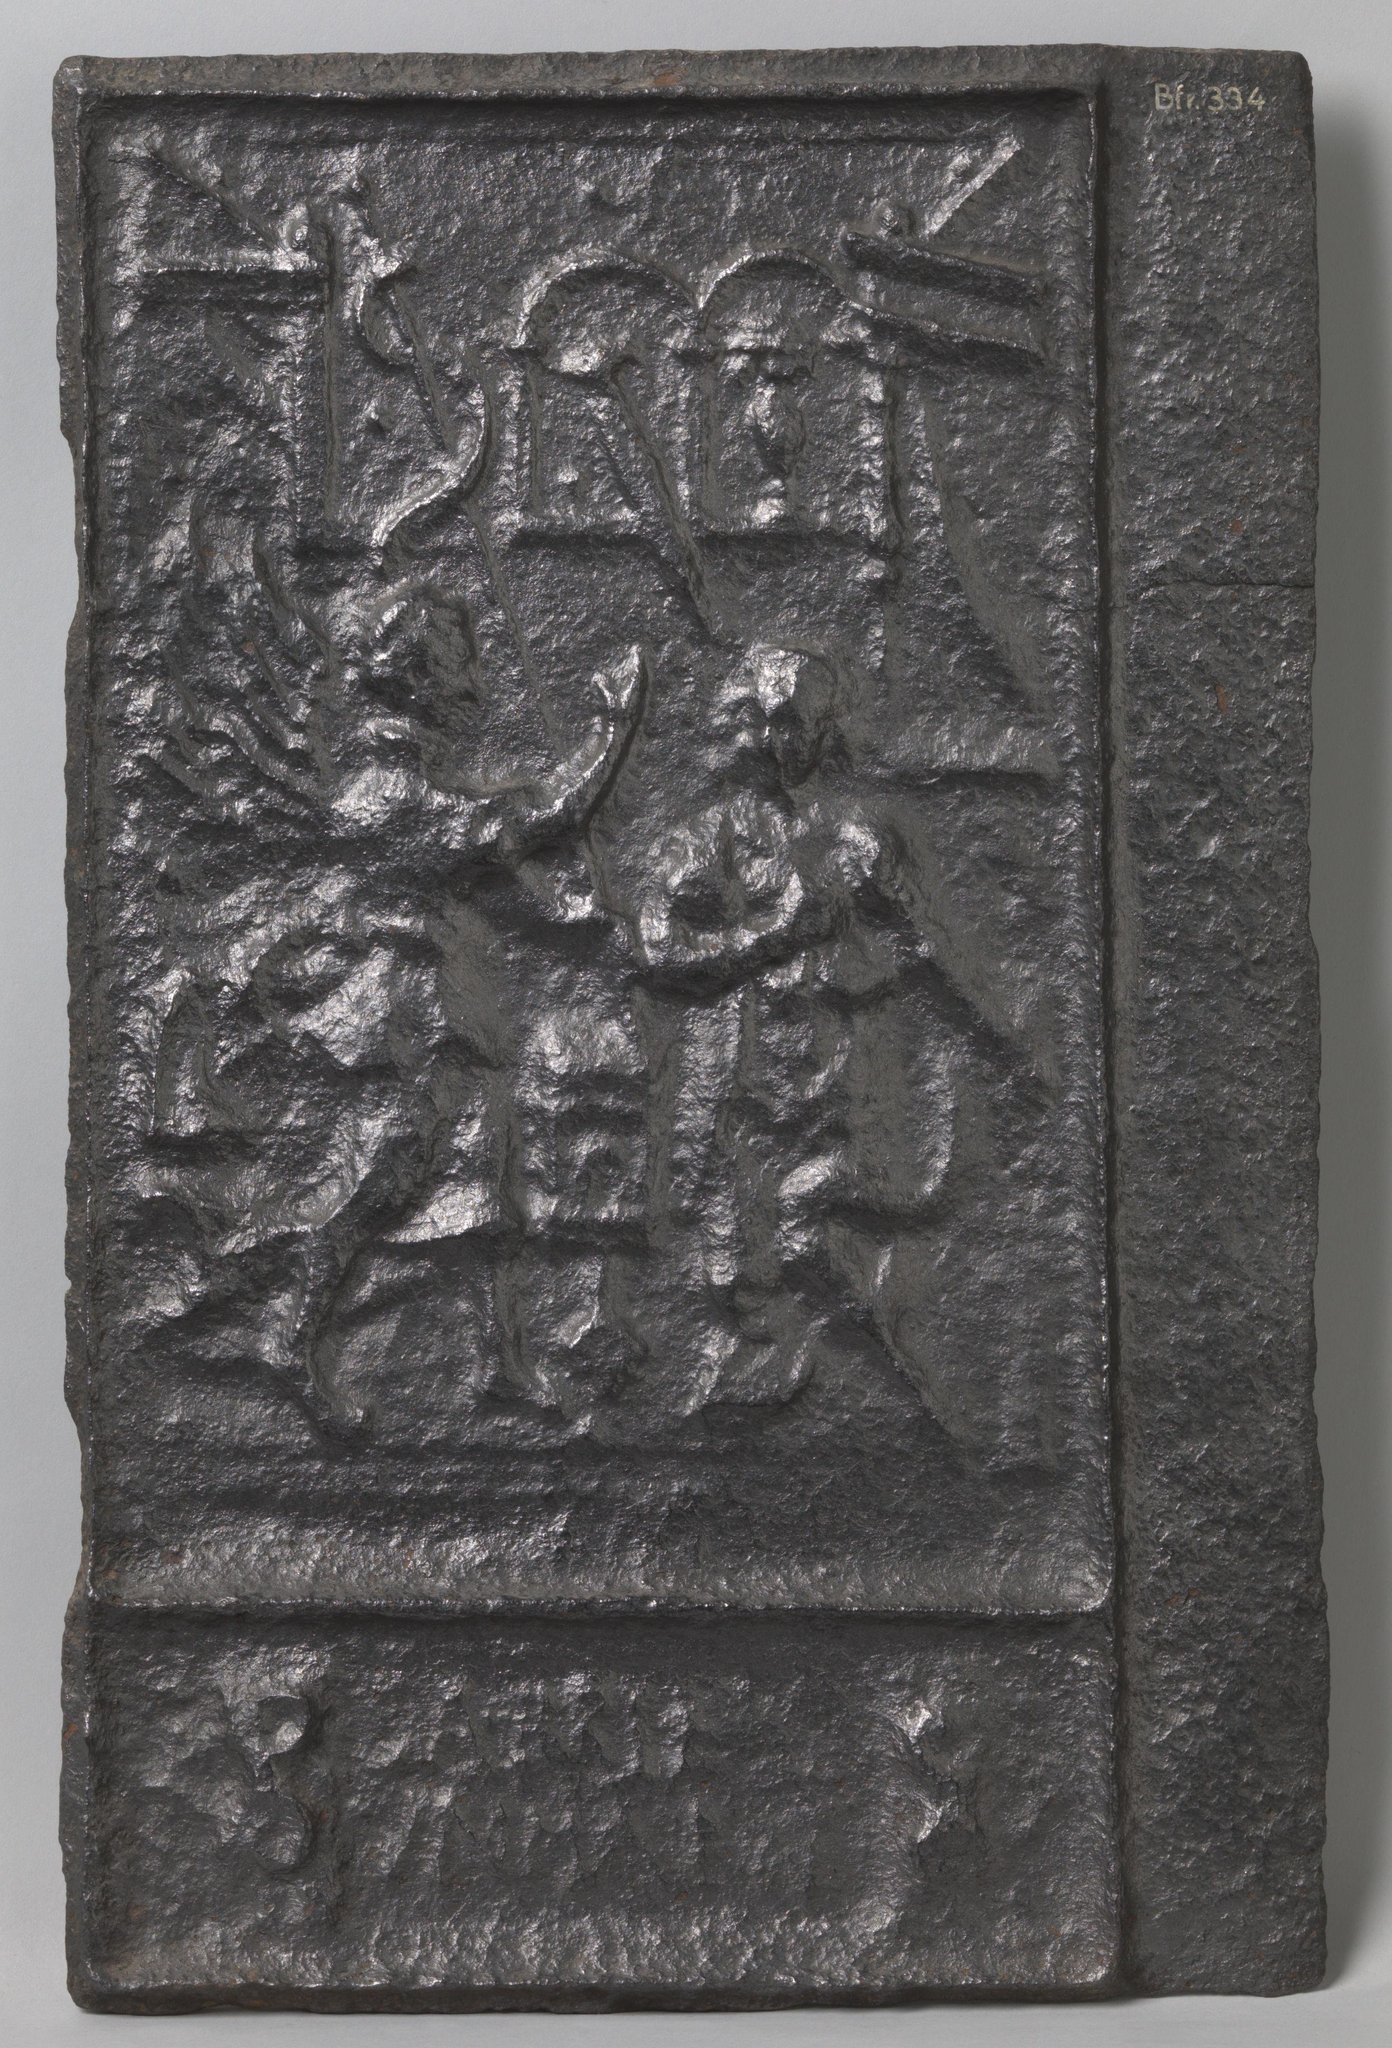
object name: stove plate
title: Kachelplaat met de Annunciatie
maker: Anonymous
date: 1575-1625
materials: iron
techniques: casting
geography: germany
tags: the annunciation: mary, usually reading, is visited by the angel (sometimes a woman overhears the conversation)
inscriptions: inscription: ‘GABRIEL / [...]’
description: Kachelplaat van gietijzer, verdeeld in twee zones. In de bovenste zone is een voorstelling van de Annunciatie, waarbij de engel links aan Maria haar zwangerschap verkondigd. Bovenaan het tafereel zijn enkele bogen te zien, onder één daarvan staat een vaas met een lelie. De onderste zone is voorzien van een cartouche met opschrift: GABRIEL.